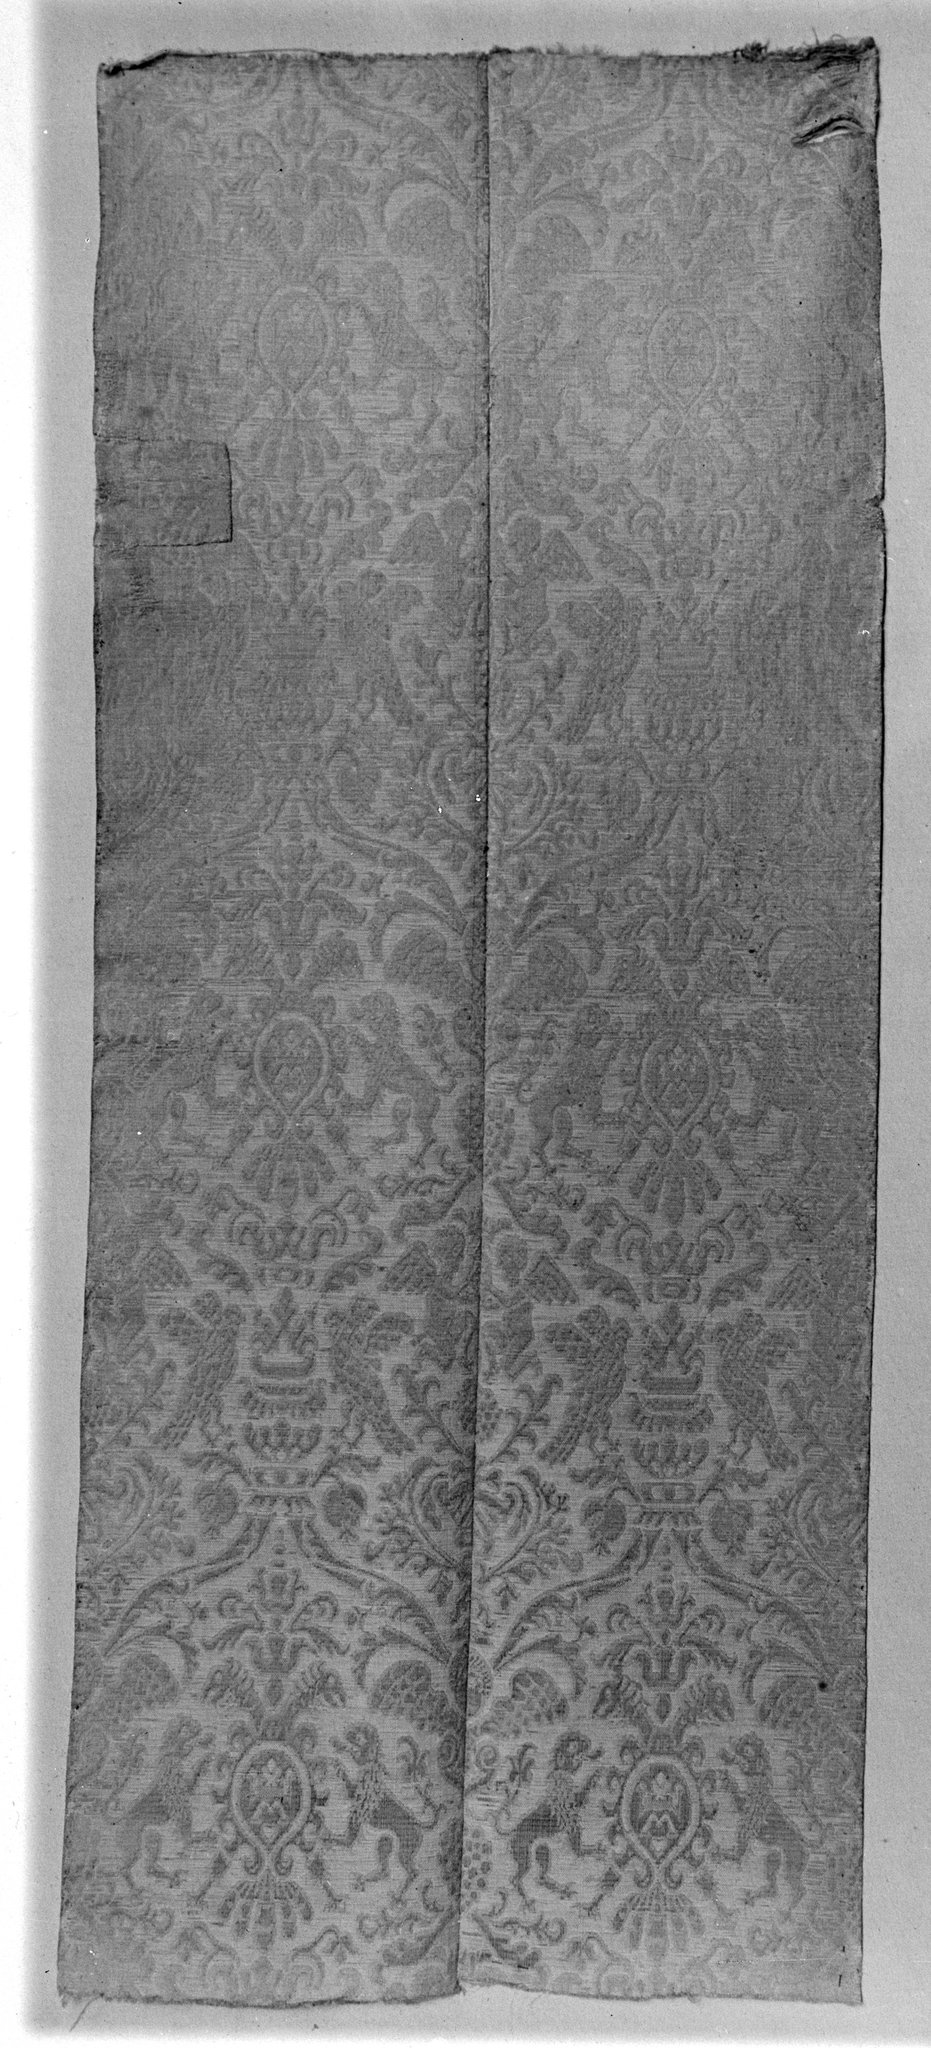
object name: piece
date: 1501-1600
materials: linen, silk